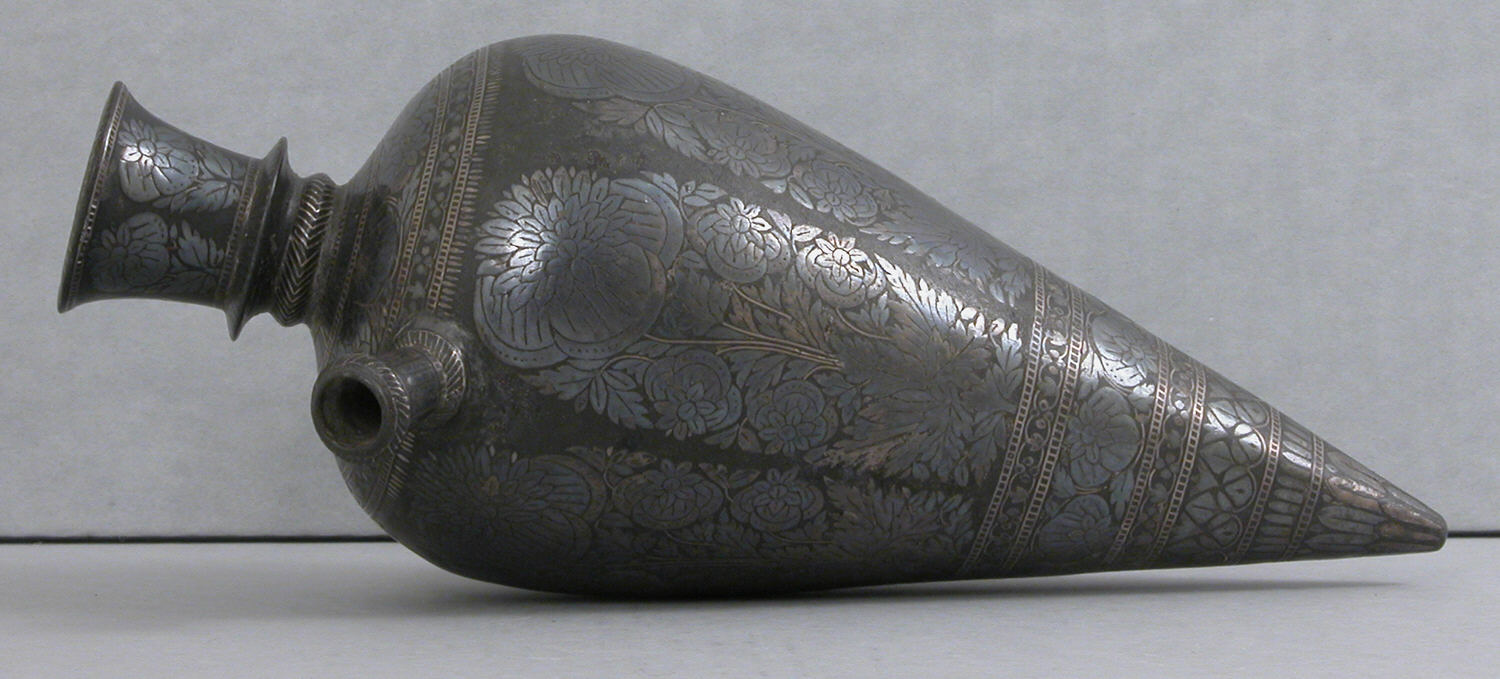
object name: water pipe base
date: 1701-1900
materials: alloy, brass, silver, zinc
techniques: casting, engraving, inlay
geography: india